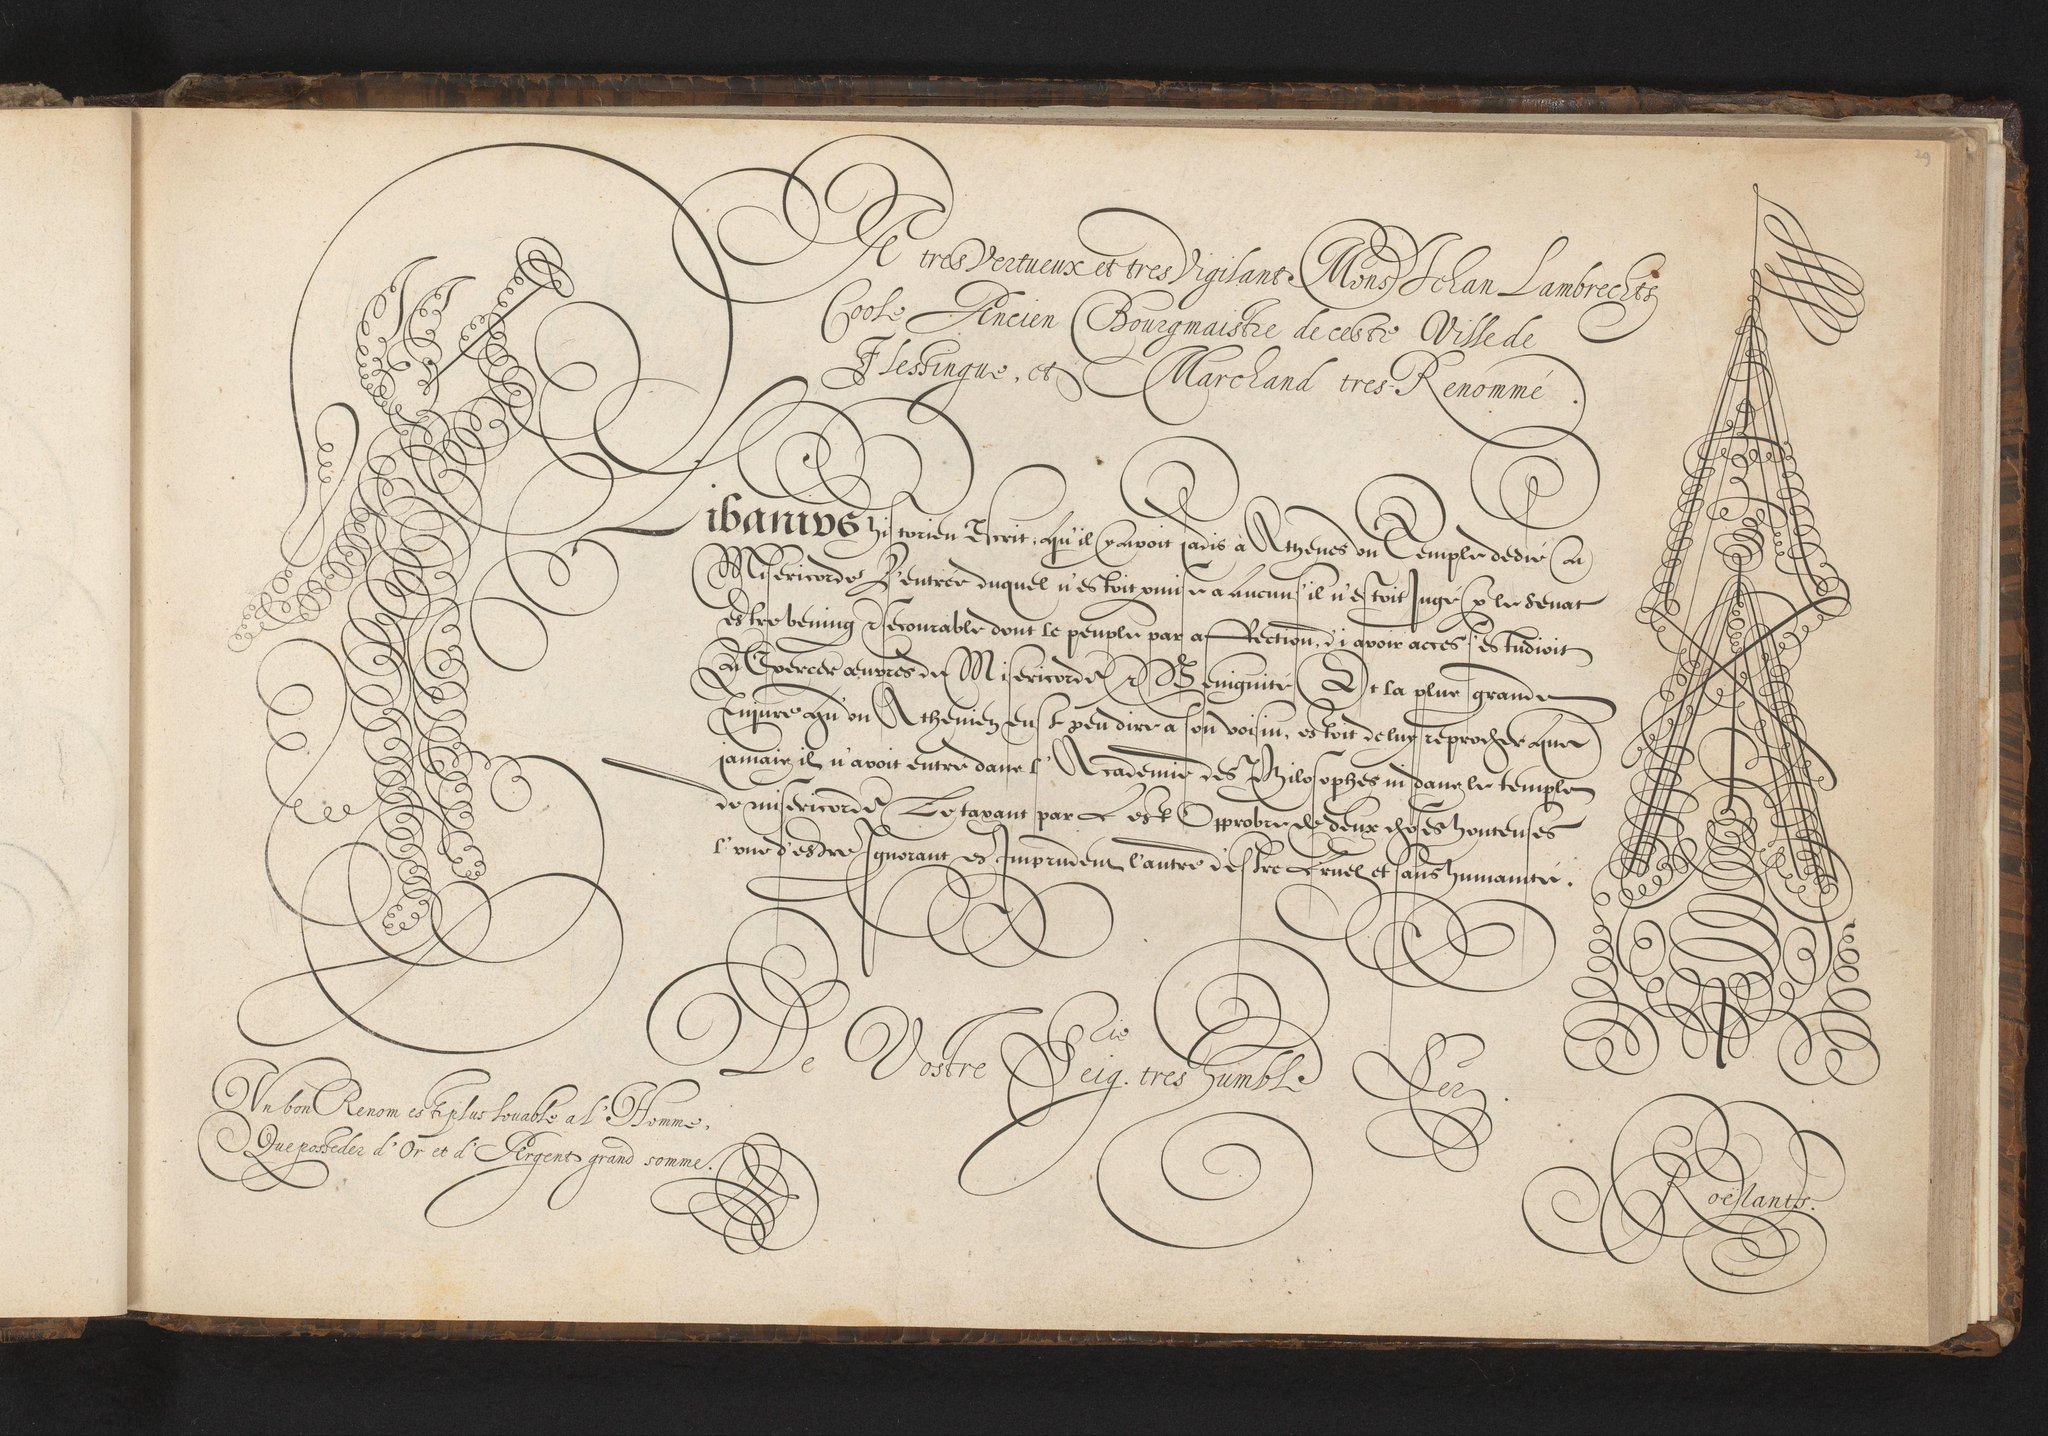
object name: album leaf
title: 't Magazin oft pac-huys der loffelycker penn-const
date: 1616-1617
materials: paper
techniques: engraving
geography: flushing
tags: calligraphy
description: Schrijfvoorbeeld met acht regels tekst in het Frans: Libanius historien escrit ... Daarboven een drieregelige tekst met een opdracht aan Jan Lambrechtsen Coolen. De tekst wordt geflankeerd door Faam en een schip in krulwerk. De prent maakt deel uit van een album.